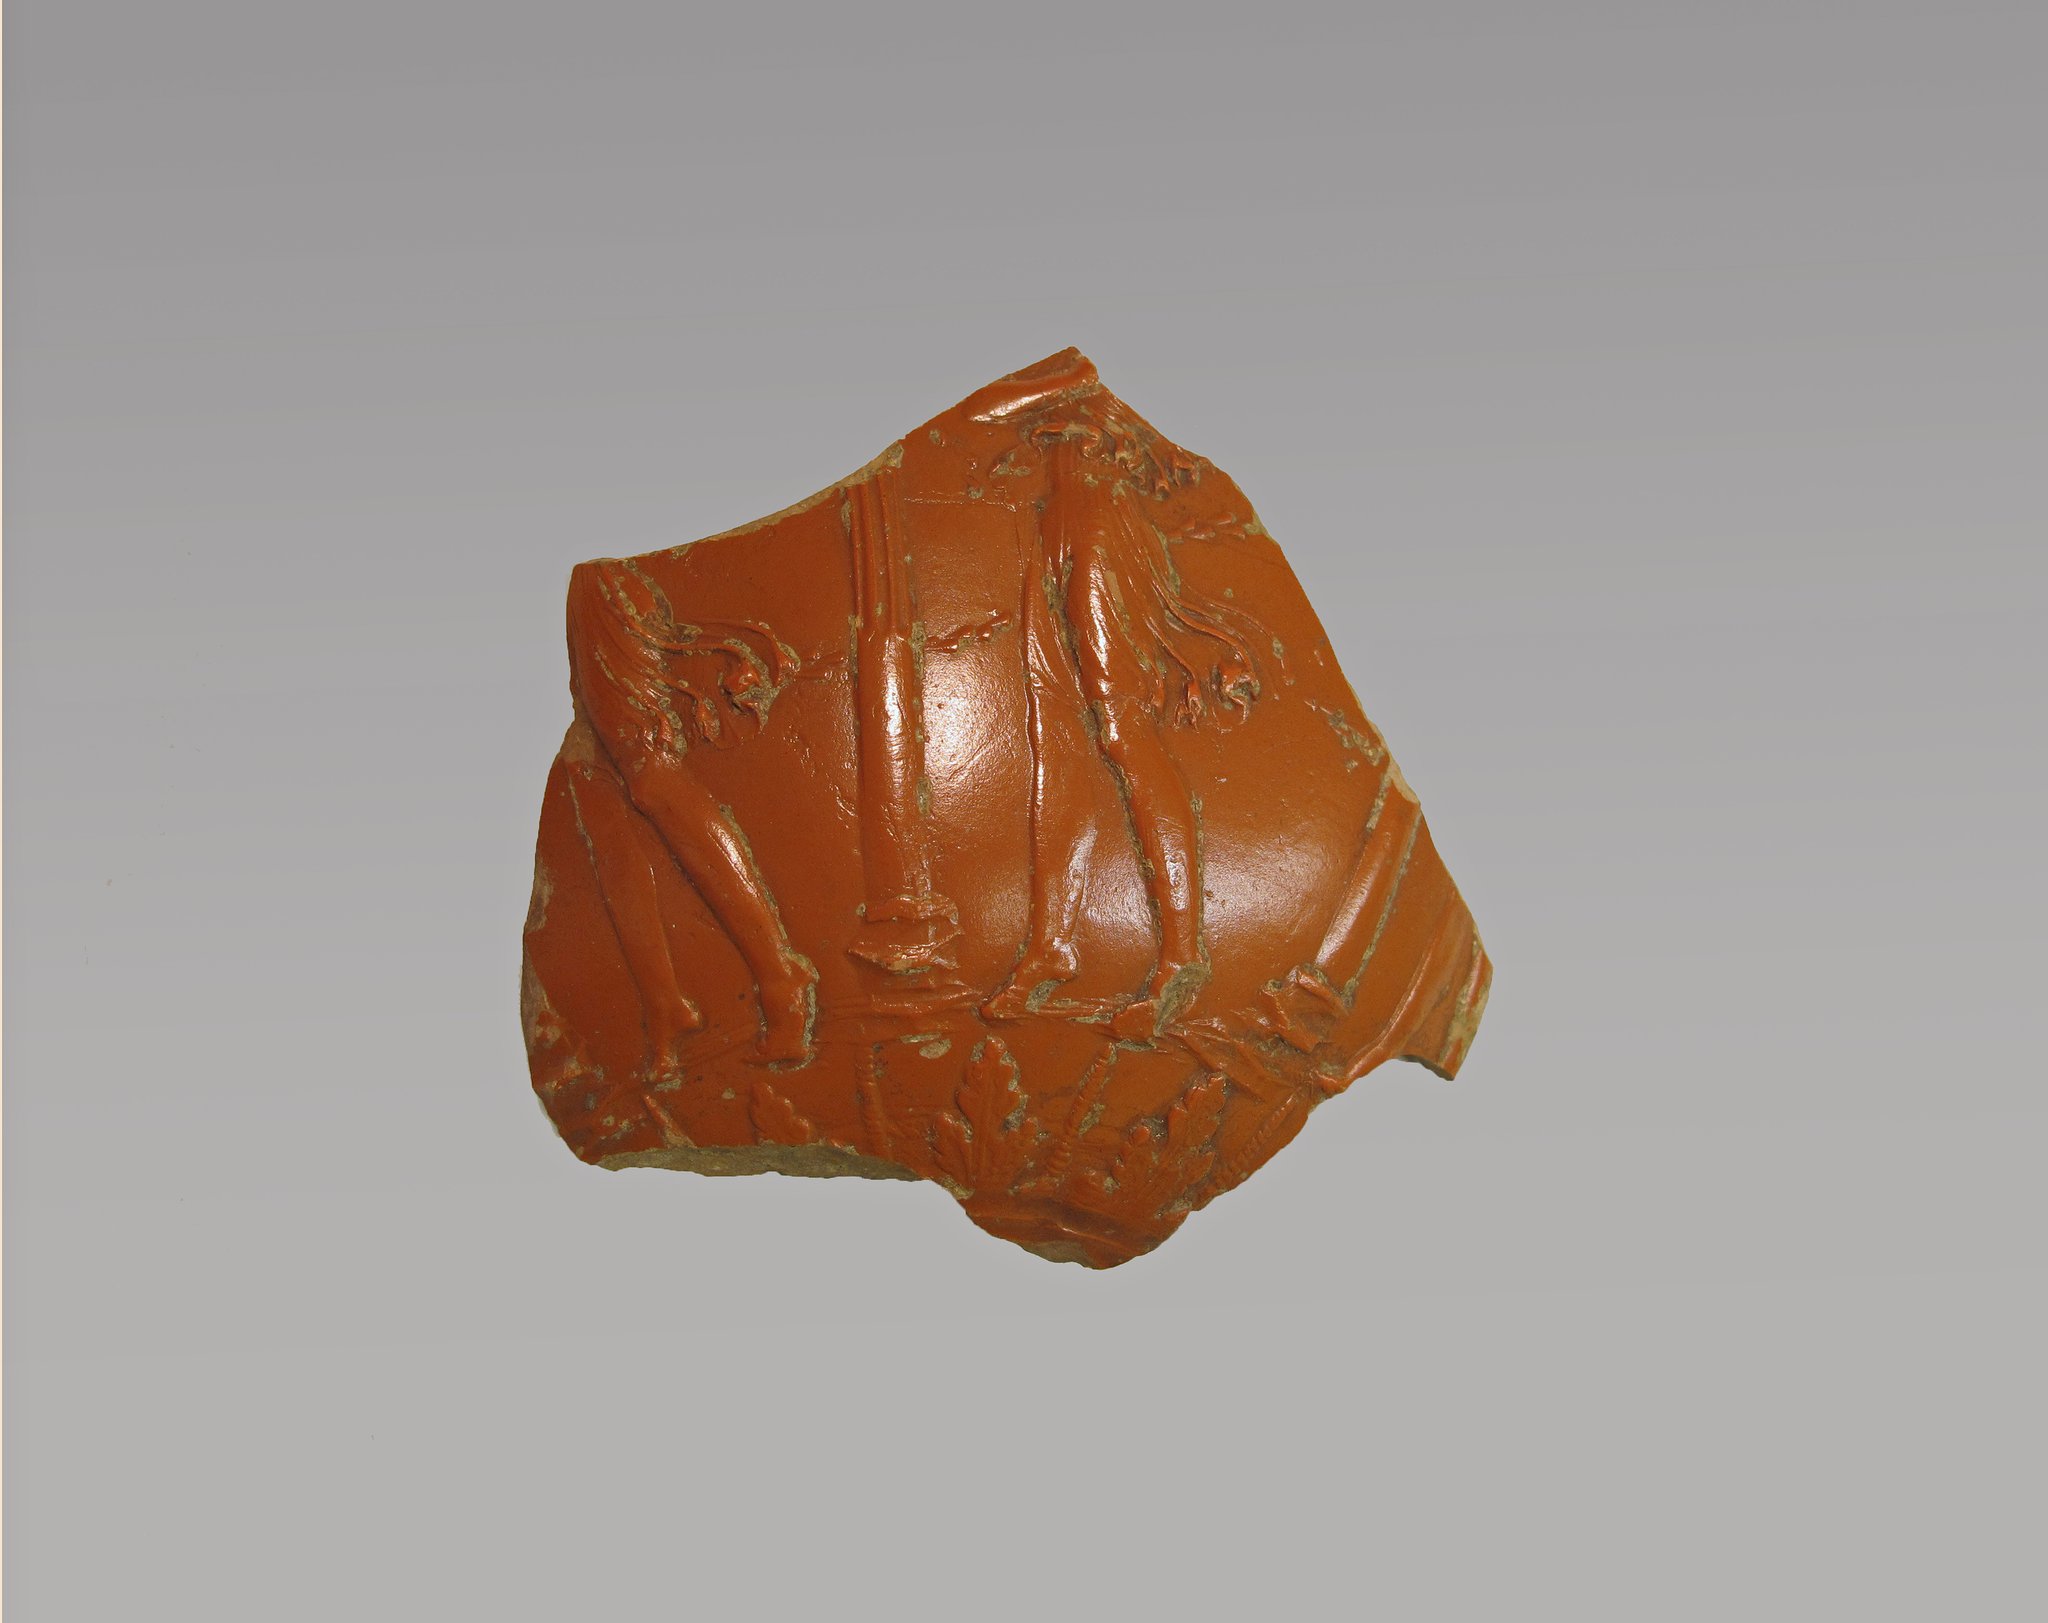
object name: vase fragment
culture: roman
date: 100 BCE-100 CE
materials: terracotta